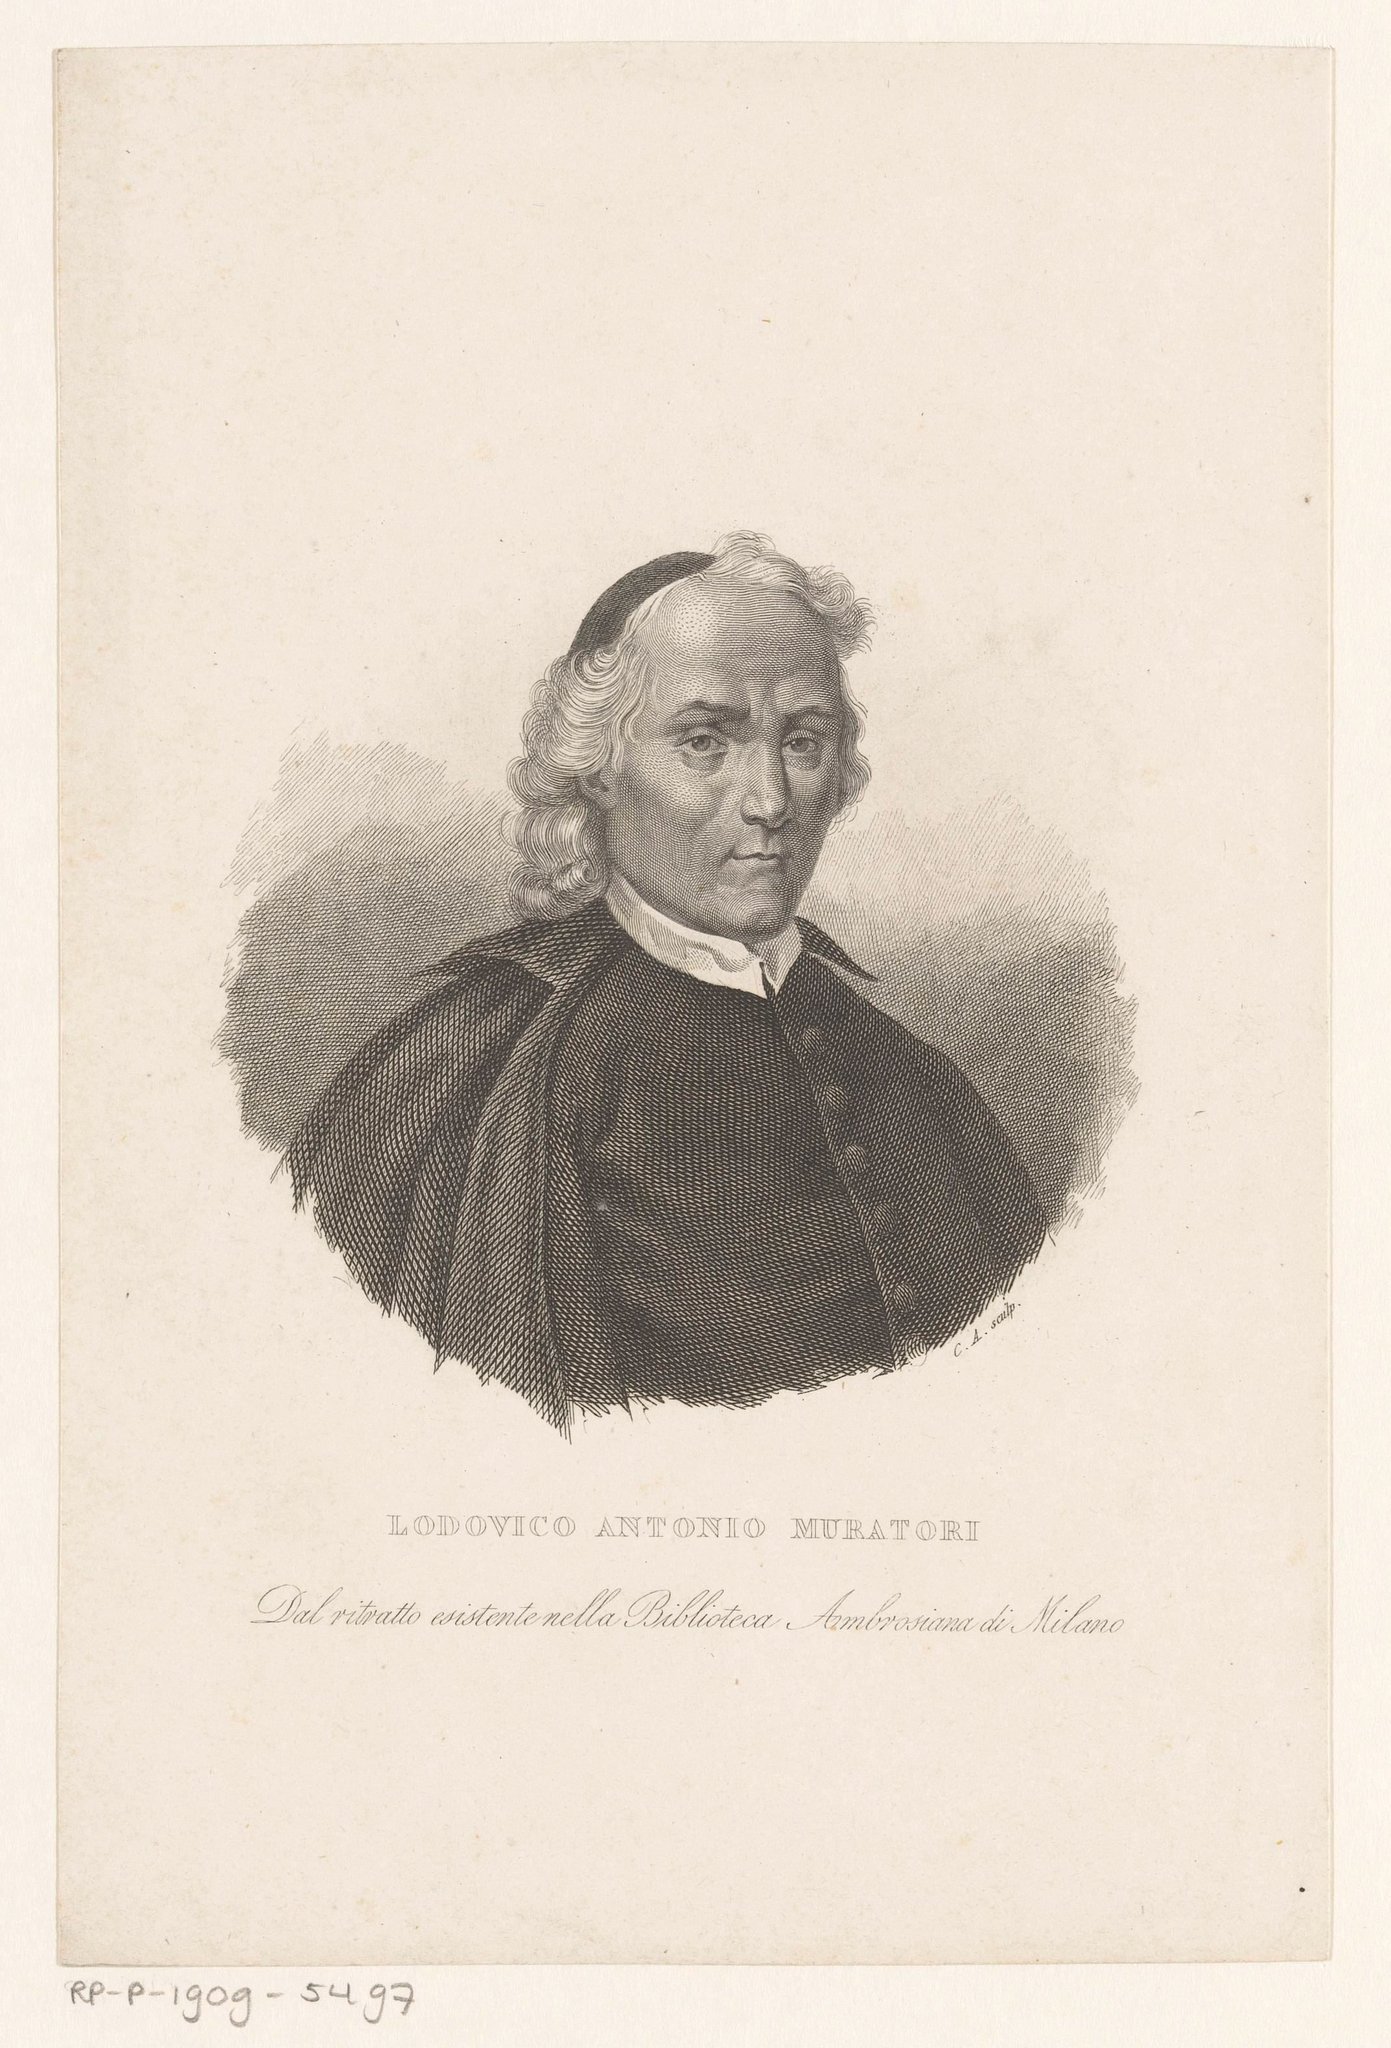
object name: print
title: Portret van schrijver en historicus Ludovico Antonio Muratori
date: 1800-1899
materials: paper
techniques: engraving, etching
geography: italy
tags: historical persons, writer, poet, author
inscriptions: collector's mark: Lugt 2228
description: Naar een schilderij door een anonieme schilder, in de Biblioteca Ambrosiana te Milaan.